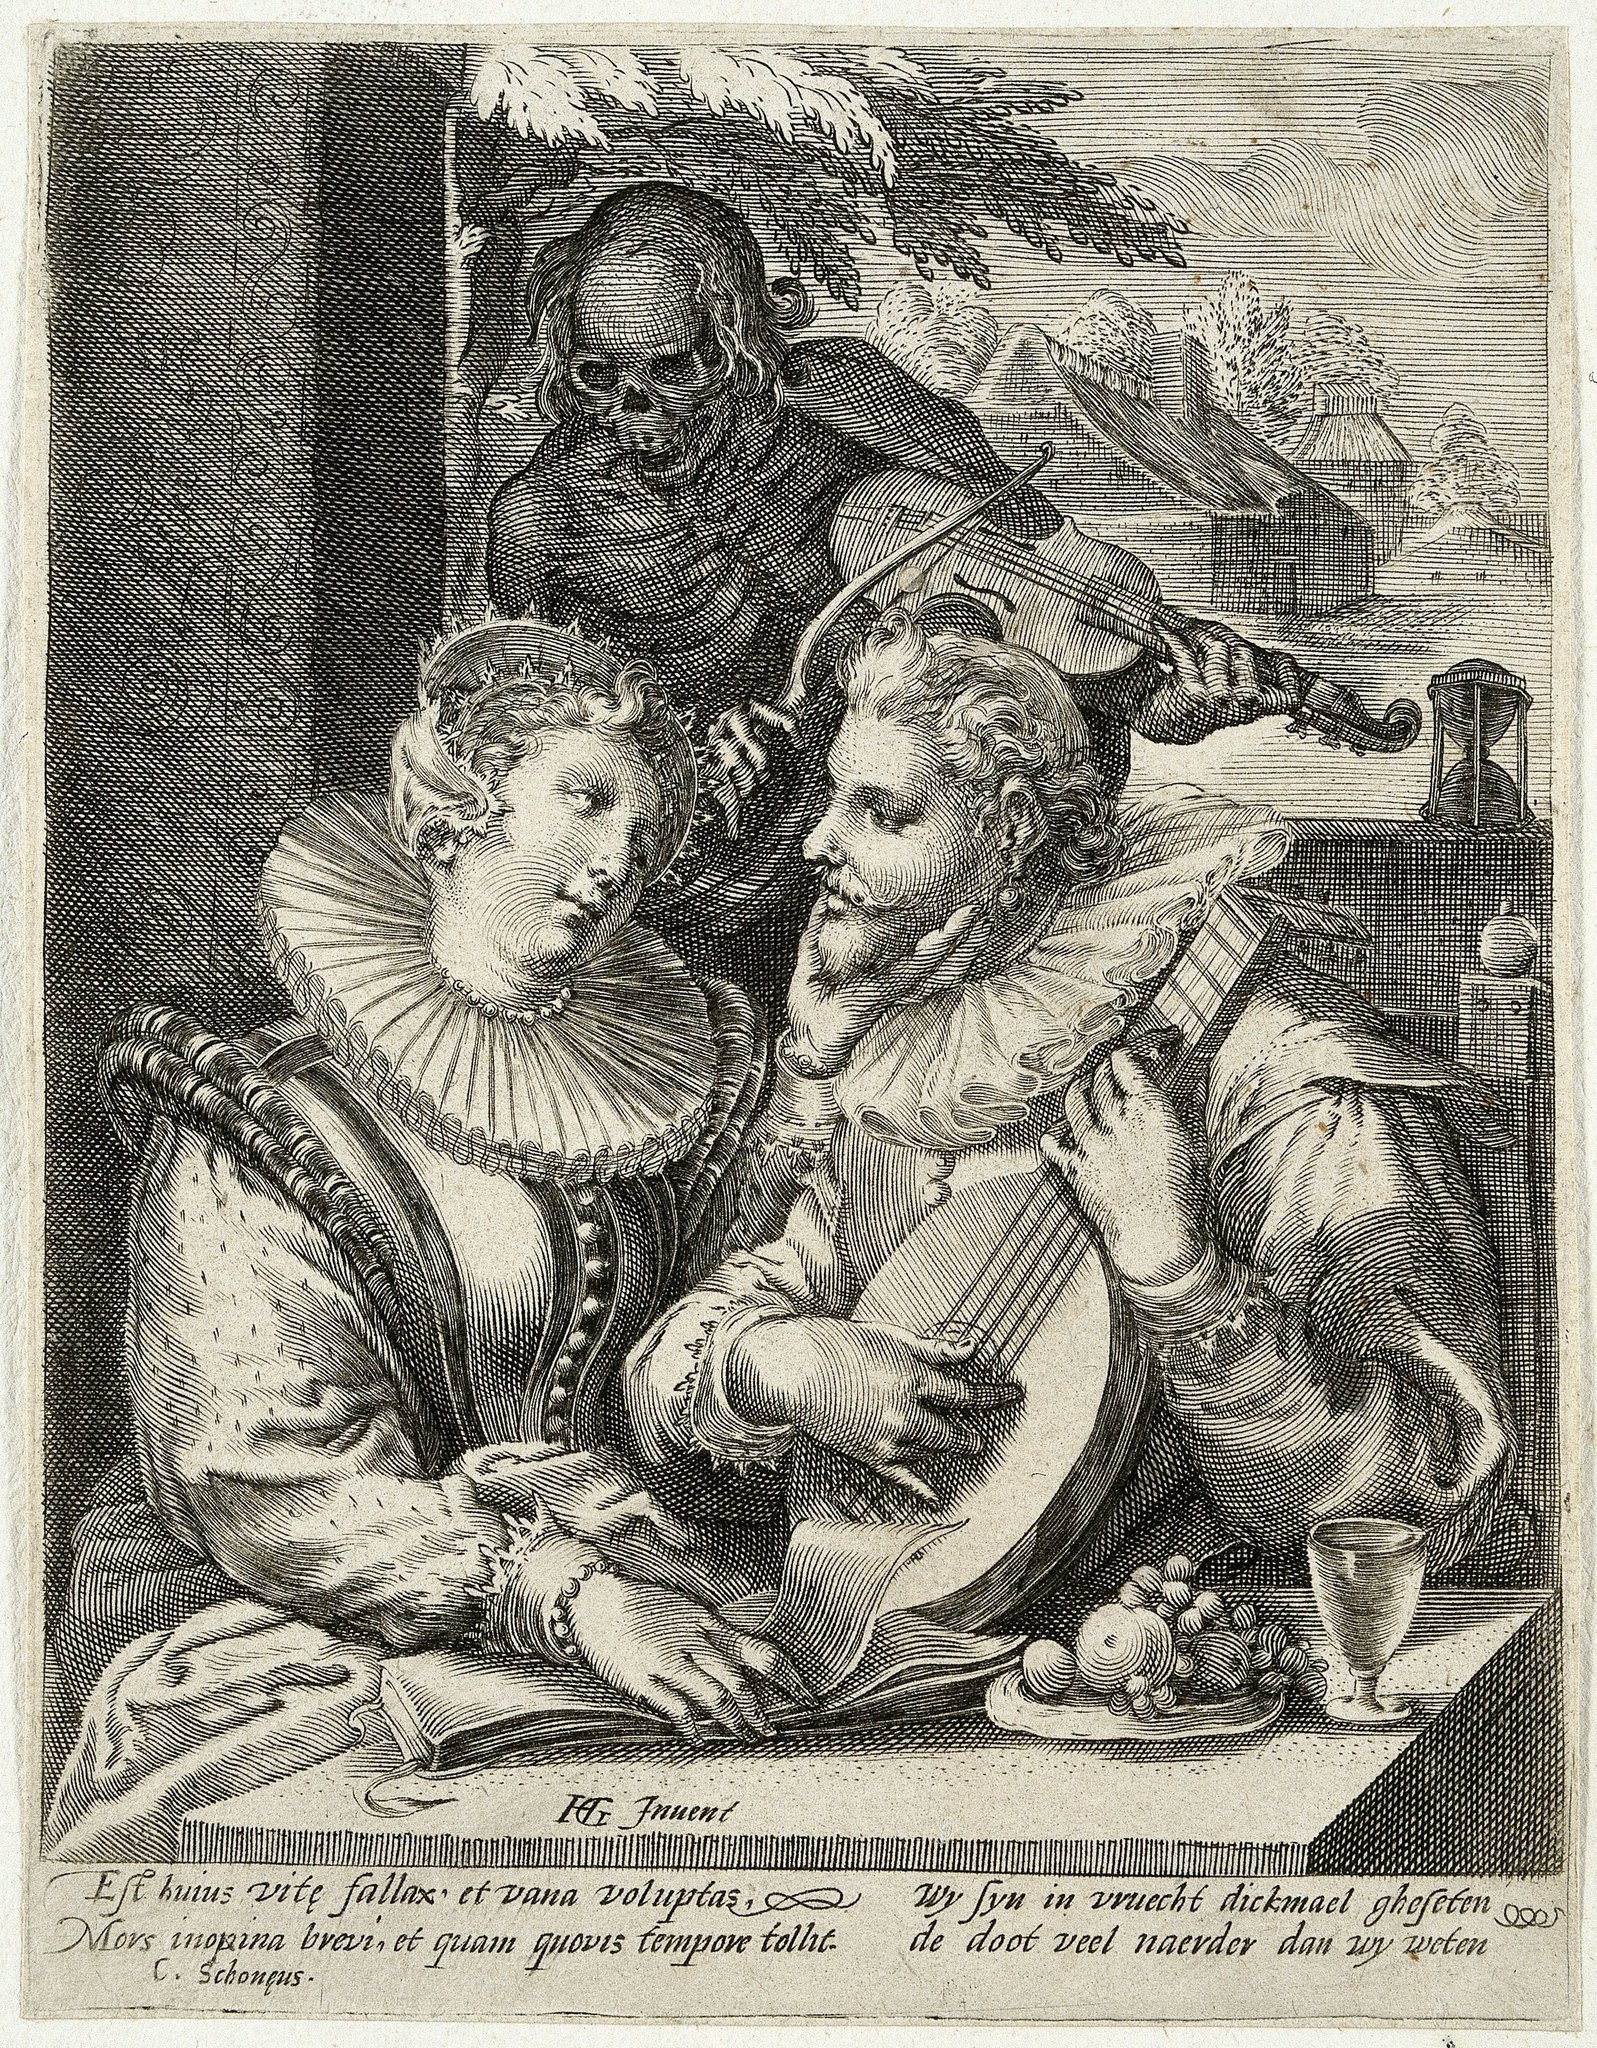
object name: print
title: Liefdespaar en de Dood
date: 1590-1610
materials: paper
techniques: engraving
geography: netherlands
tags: scenes symbolizing 'vanitas', death as skeleton, death battling with life, or with the living, proverbs, sayings, etc., couple of lovers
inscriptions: signature: ‘HG Invent’, caption: ‘Est huius vite fallax...tempore tollit’, caption: ‘Wy syn in vruecht dickmael gheseten / de doot veel naerder dan wy weten’, collector's mark: Lugt 2228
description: Liefdespaar, musicerend aan tafel. De dame heeft een zangboekje voor zich, de man bespeelt de luit. Achter hen de Dood in de gedaante van een vioolspelende magere figuur met doodshoofd. Op de vensterbank een zandloper. Met onderschrift in Latijn en Nederlands ('Wy syn in vruecht dickmael gheseten / de doot veel naerder dan wy weten').